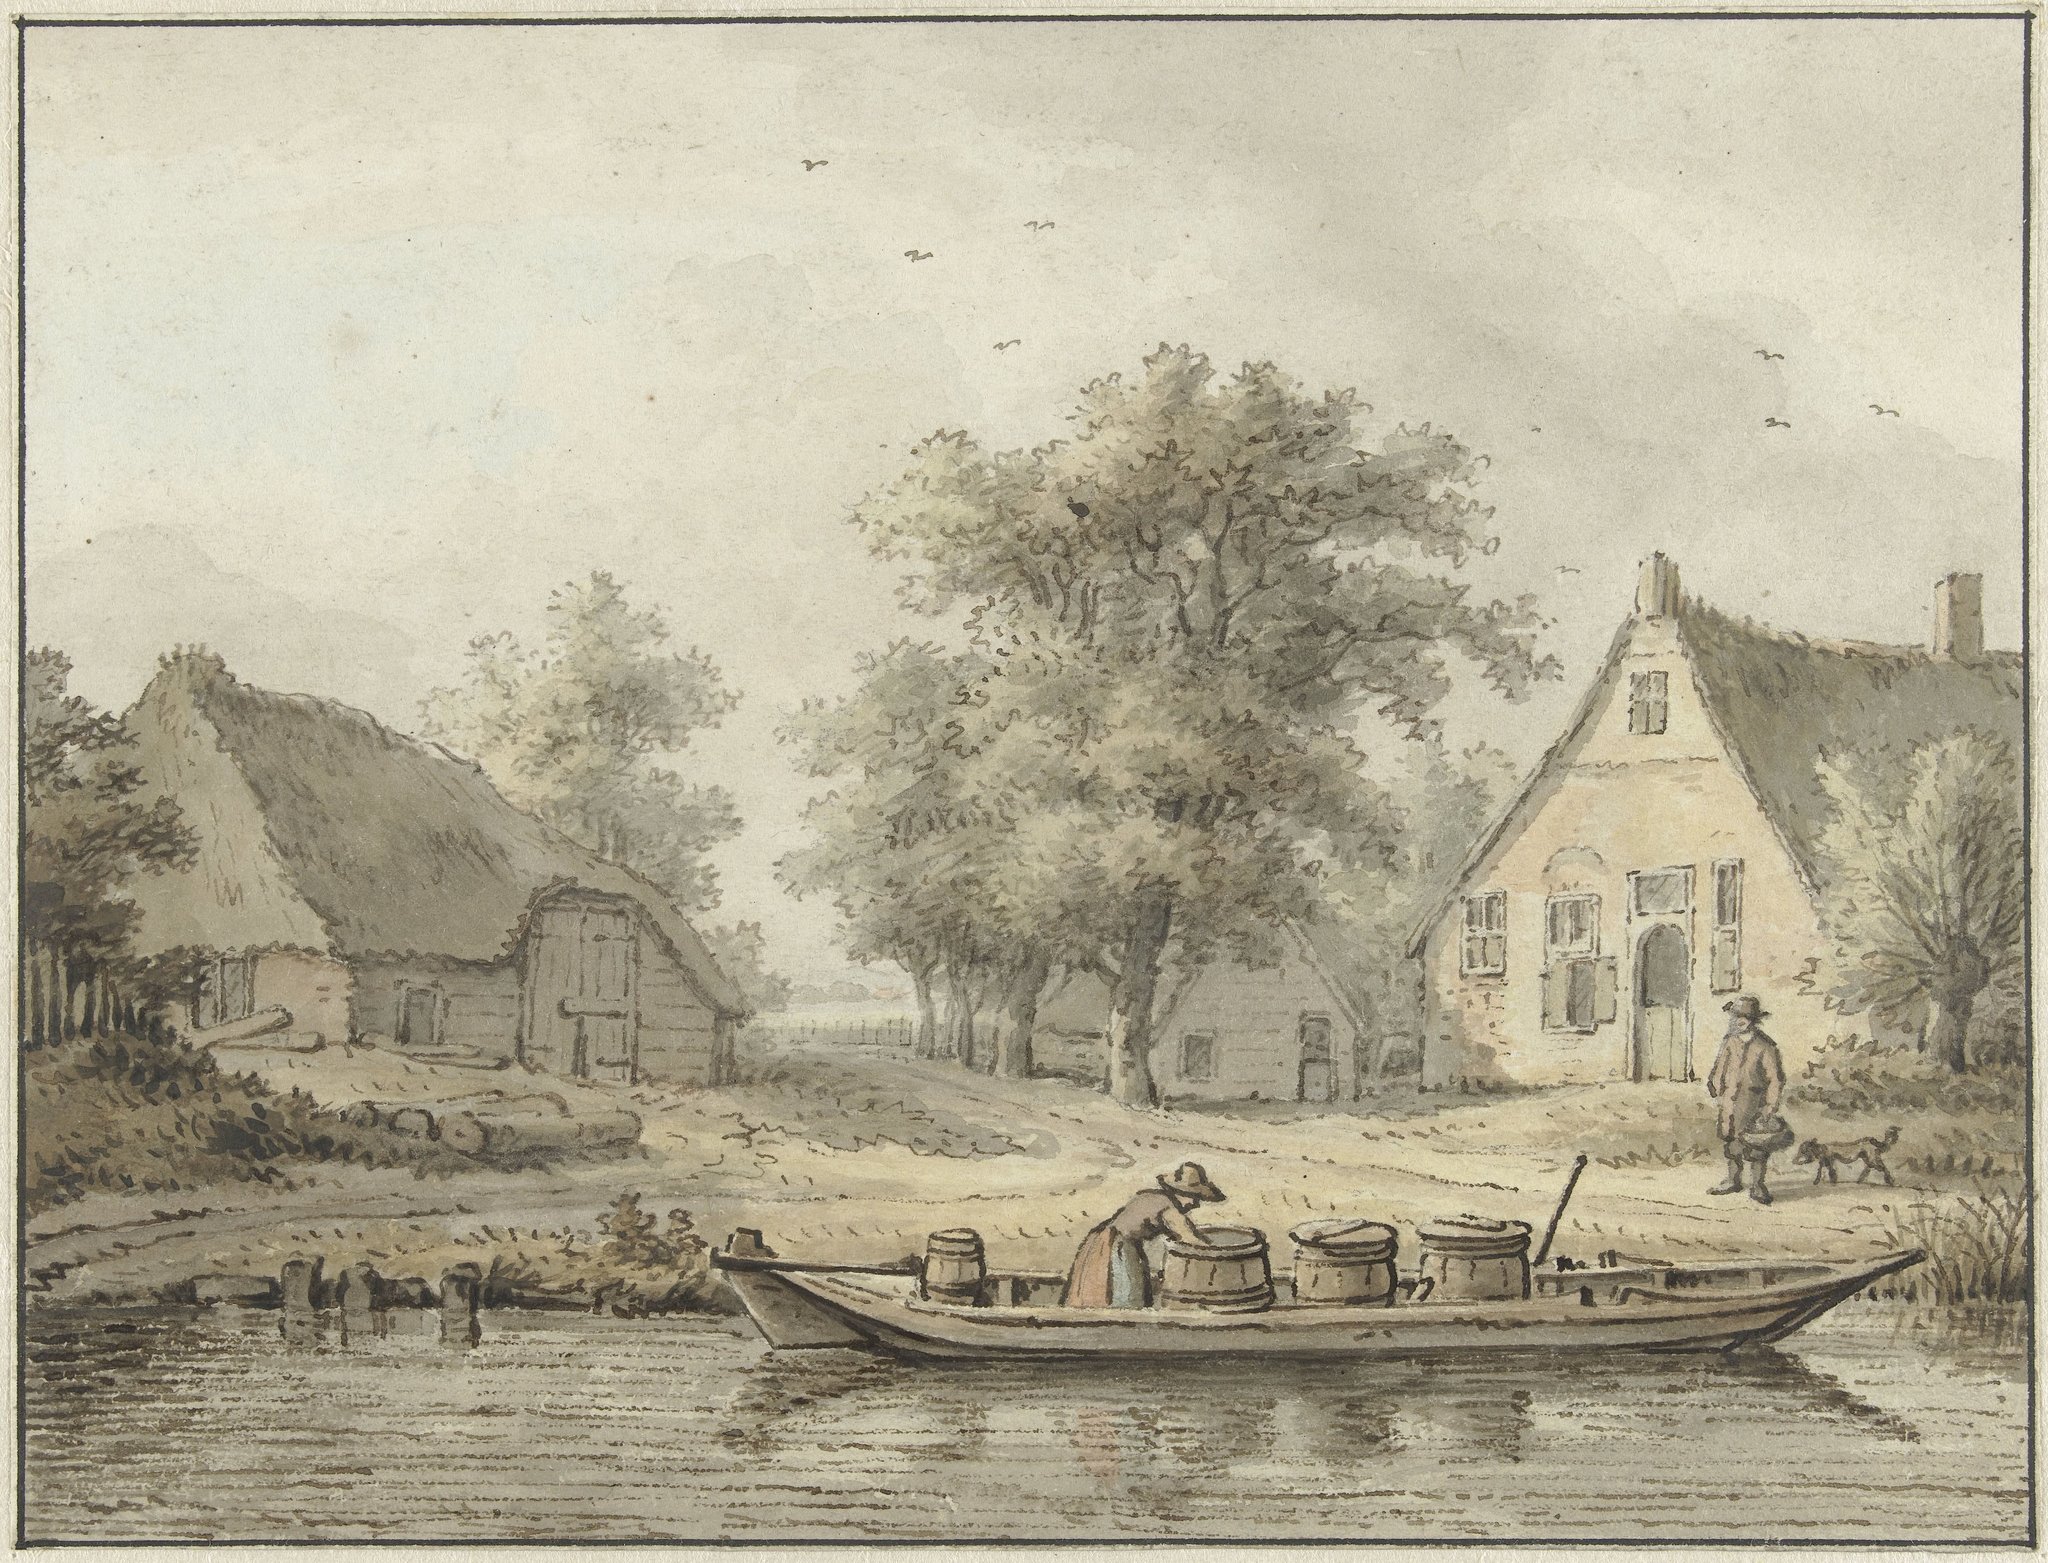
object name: drawing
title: Landschap met afgemeerde schuit met vaten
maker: cornelis buys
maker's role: draughtsman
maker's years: 1746-1826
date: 1756-1826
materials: ink, paper, watercolor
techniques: brush, pen